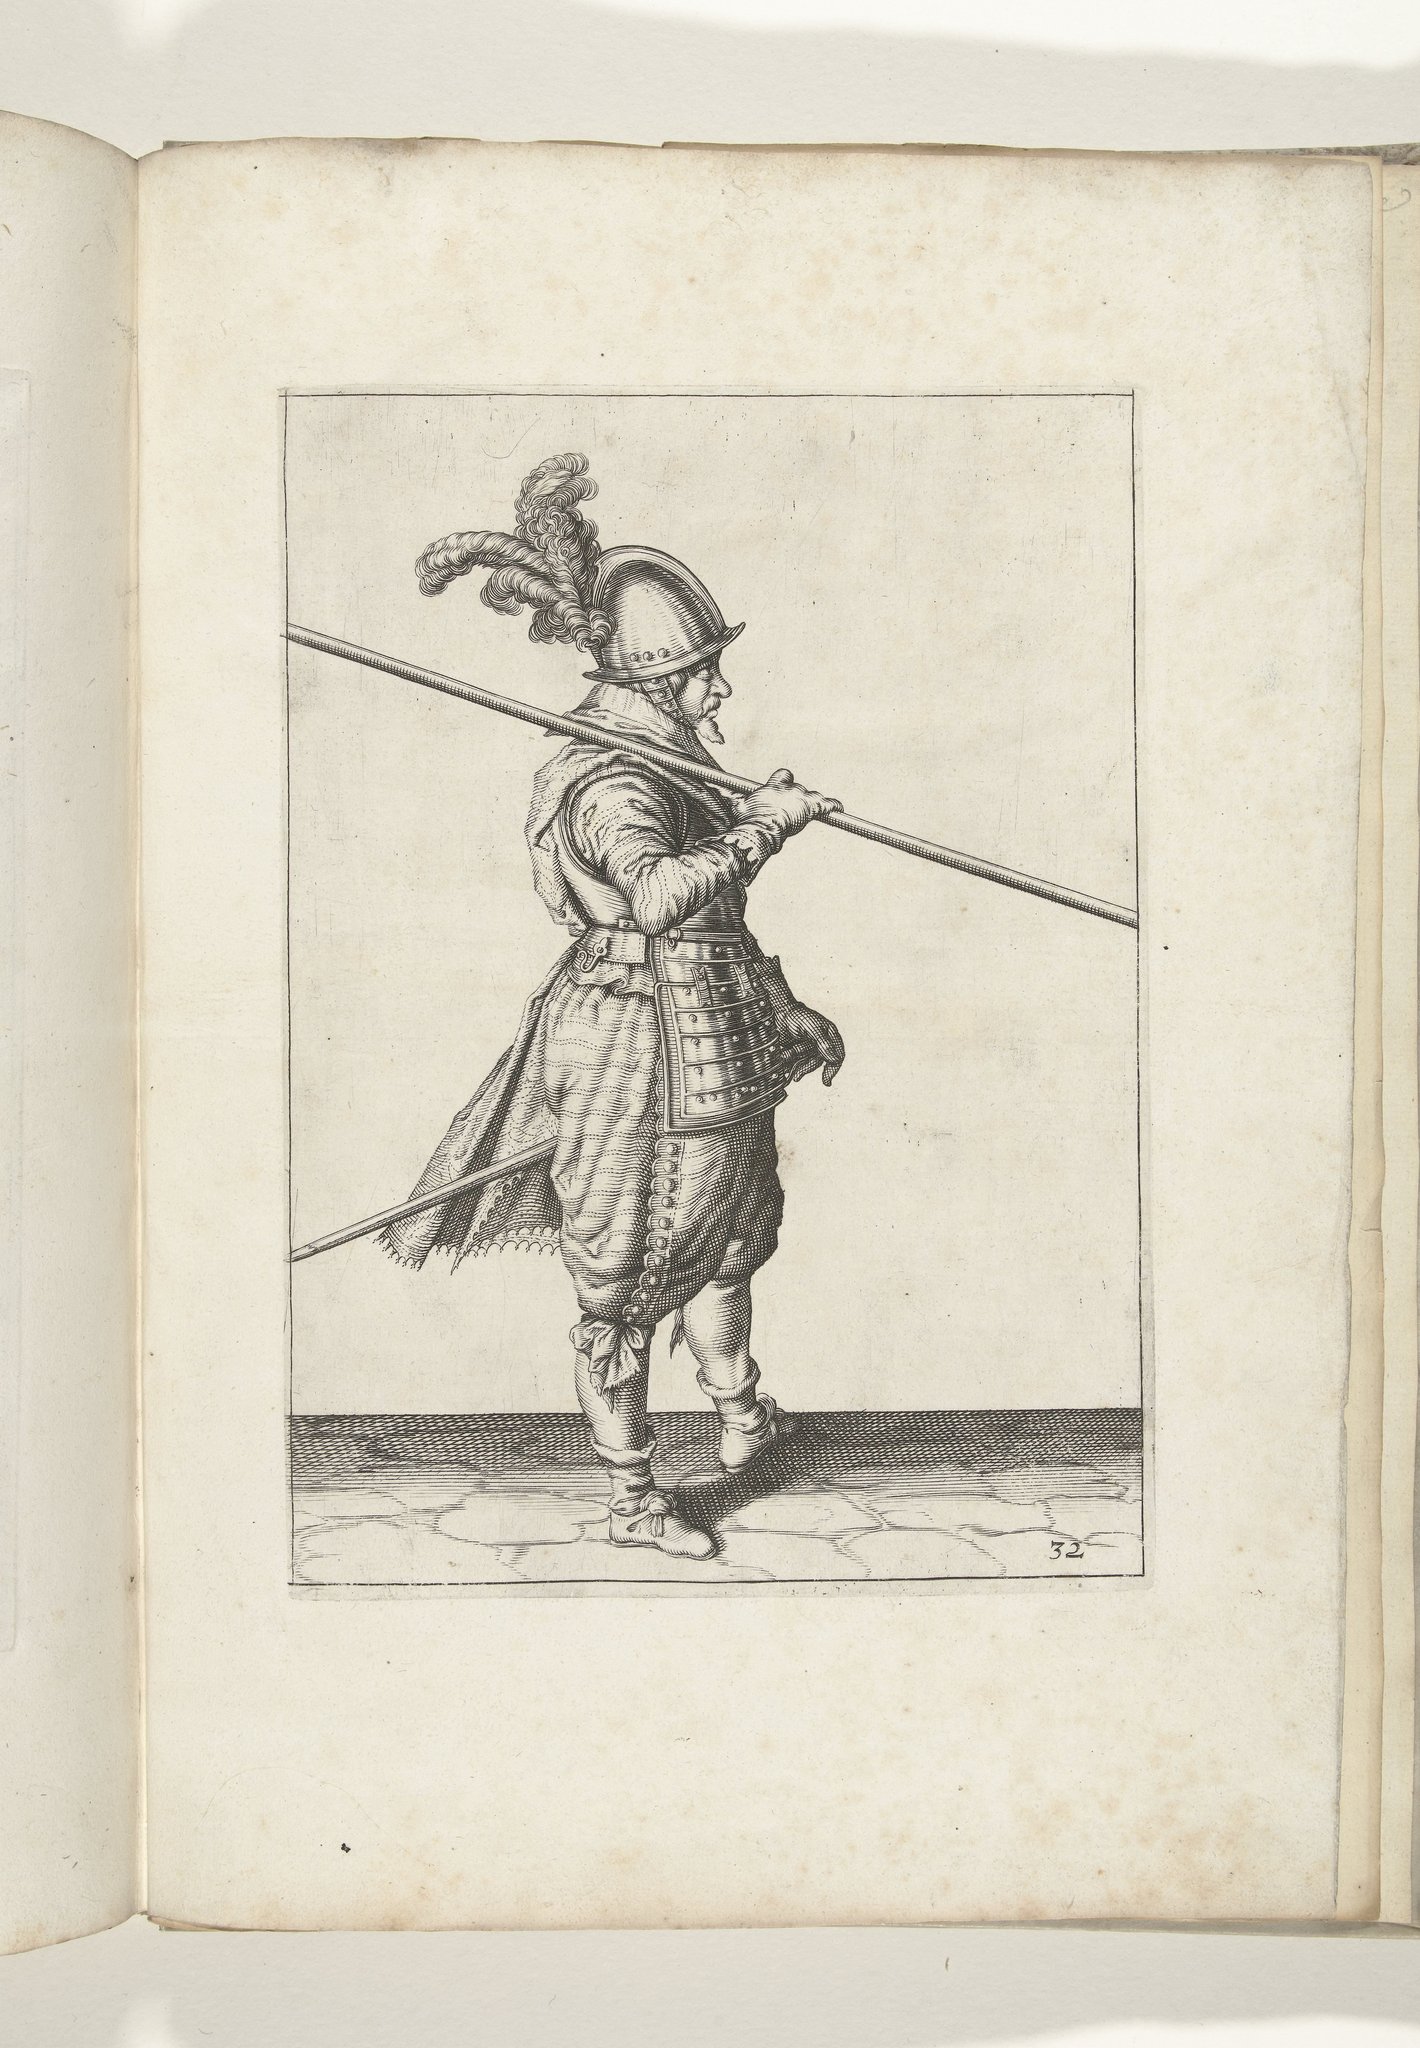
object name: print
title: Soldaat die zijn spies op zijn rechterschouder draagt, de punt schuin naar de grond gericht (nr. 32), ca. 1600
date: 1597-1607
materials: paper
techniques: engraving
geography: northern netherlands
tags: the hague, maurice (prince of orange), handling of weapons ~ military training, weapons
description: Een soldaat, ten voeten uit, naar rechts, die een spies (lans) op zijn rechterschouder draagt, de punt schuin naar de grond gericht. Zijn rechterhand om de spies (nr. 32), ca. 1600. Plaat 32 in de instructies voor het hanteren van de spies: Corte onderwysinghe op de figuerliicke afbeeldinghe, belanghende t'recht ghebruyck, van al t'ghene een Soldaet int handelen vande Spies noodich is. Onderdeel van de illustraties in: J. de Gheyn, Wapenhandelinghe van Roers Musquetten ende spiessen, 's-Gravenhage, 1607. Krijgswezen rond 1600.